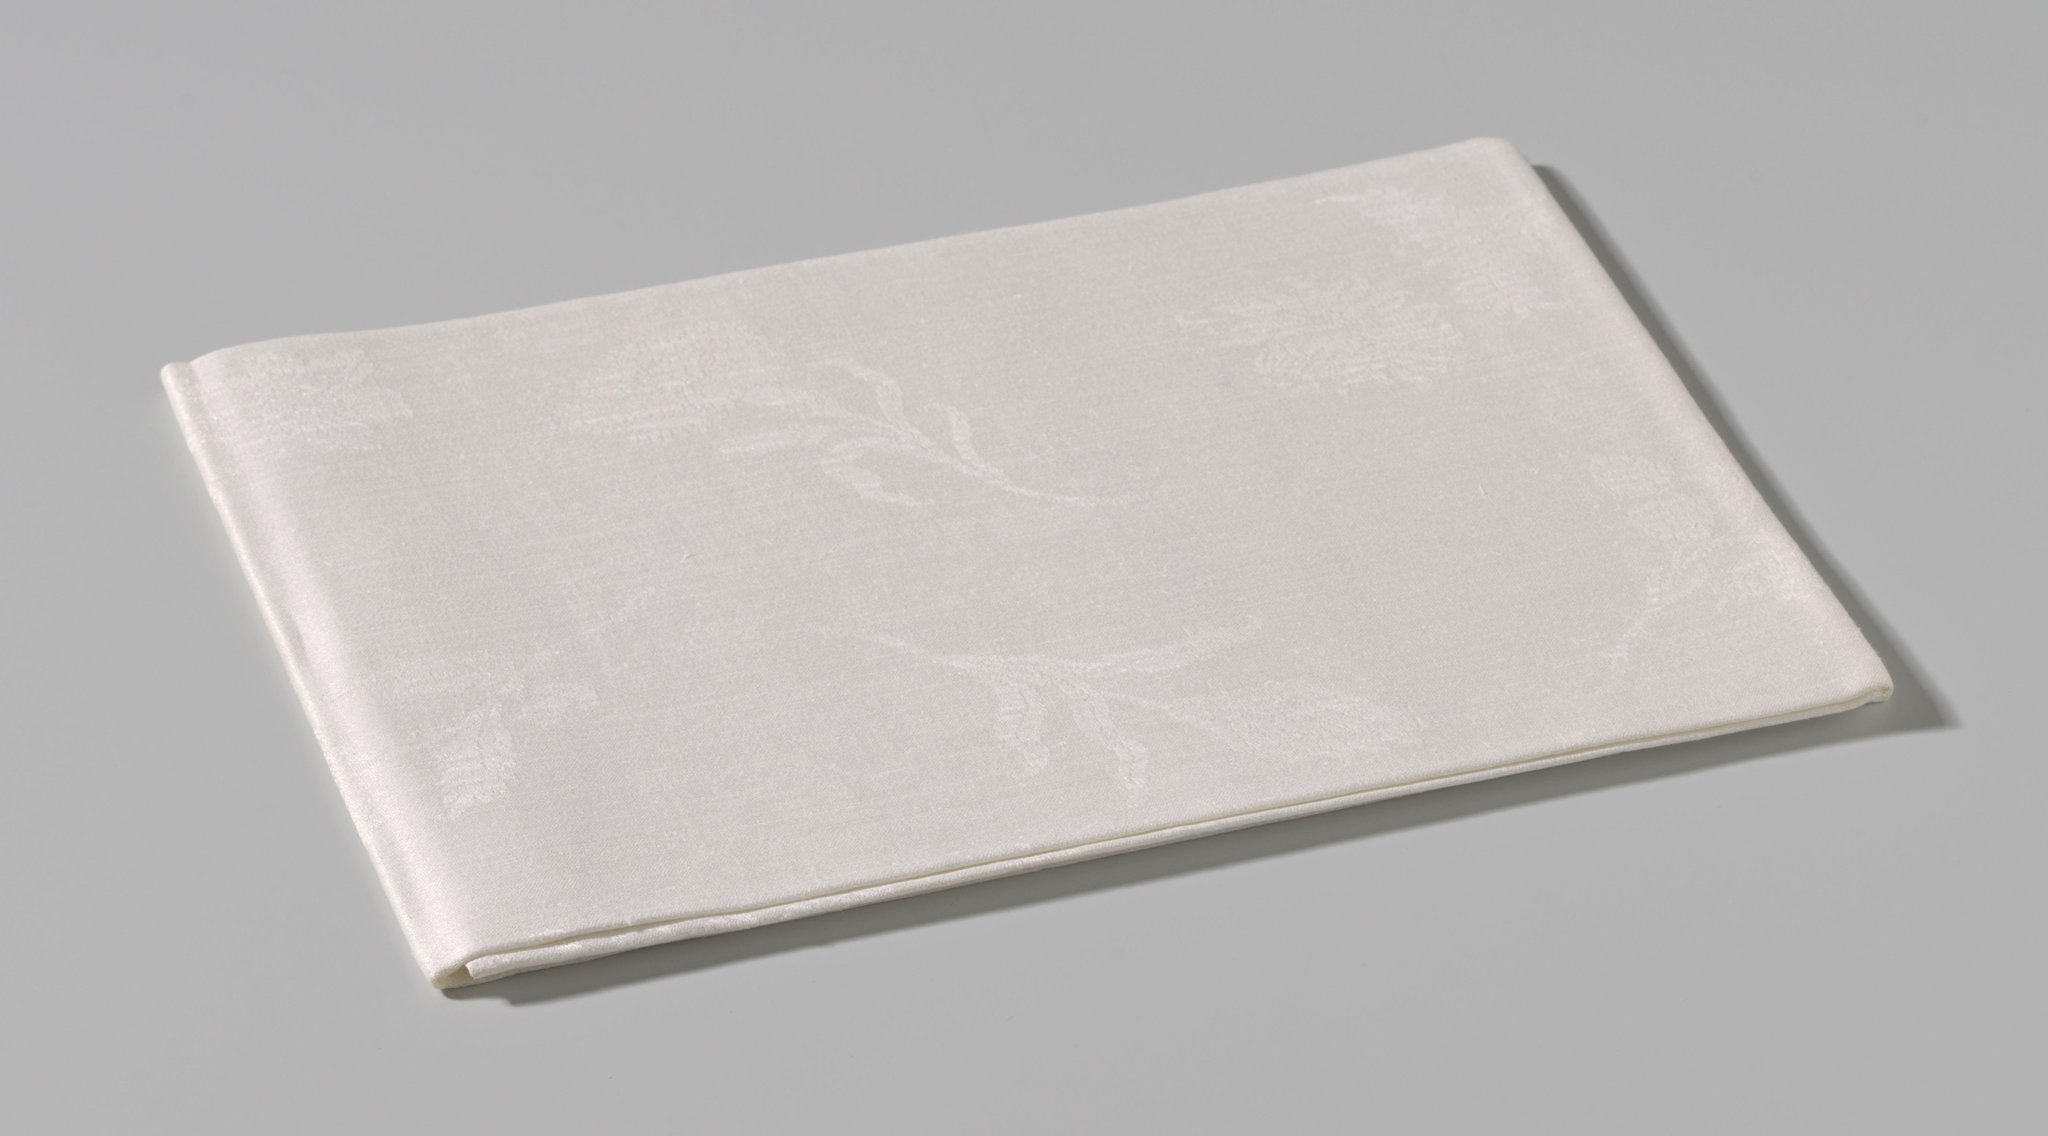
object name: napkin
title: Servet met een bloempatroon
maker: Anonymous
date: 1750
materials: linen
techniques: damask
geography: dresden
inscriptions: mark: ‘B’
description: Servet van linnendamast met een bloempatroon. Onder andere: roos, ranonkel, lelietje van dalen, anjer, tulp; met stelen die schuin en in rijen tegengesteld gericht zijn. Staande rand: dunne lopende voluutranken, waaraan onder andere kelkbloemen, papaver, chrysant, akelei, en wordt begrensd door grote asymmetrische rocaillemotieven, die op de hoeken naar het midden zijn gericht. Rondom: blokkenrand.